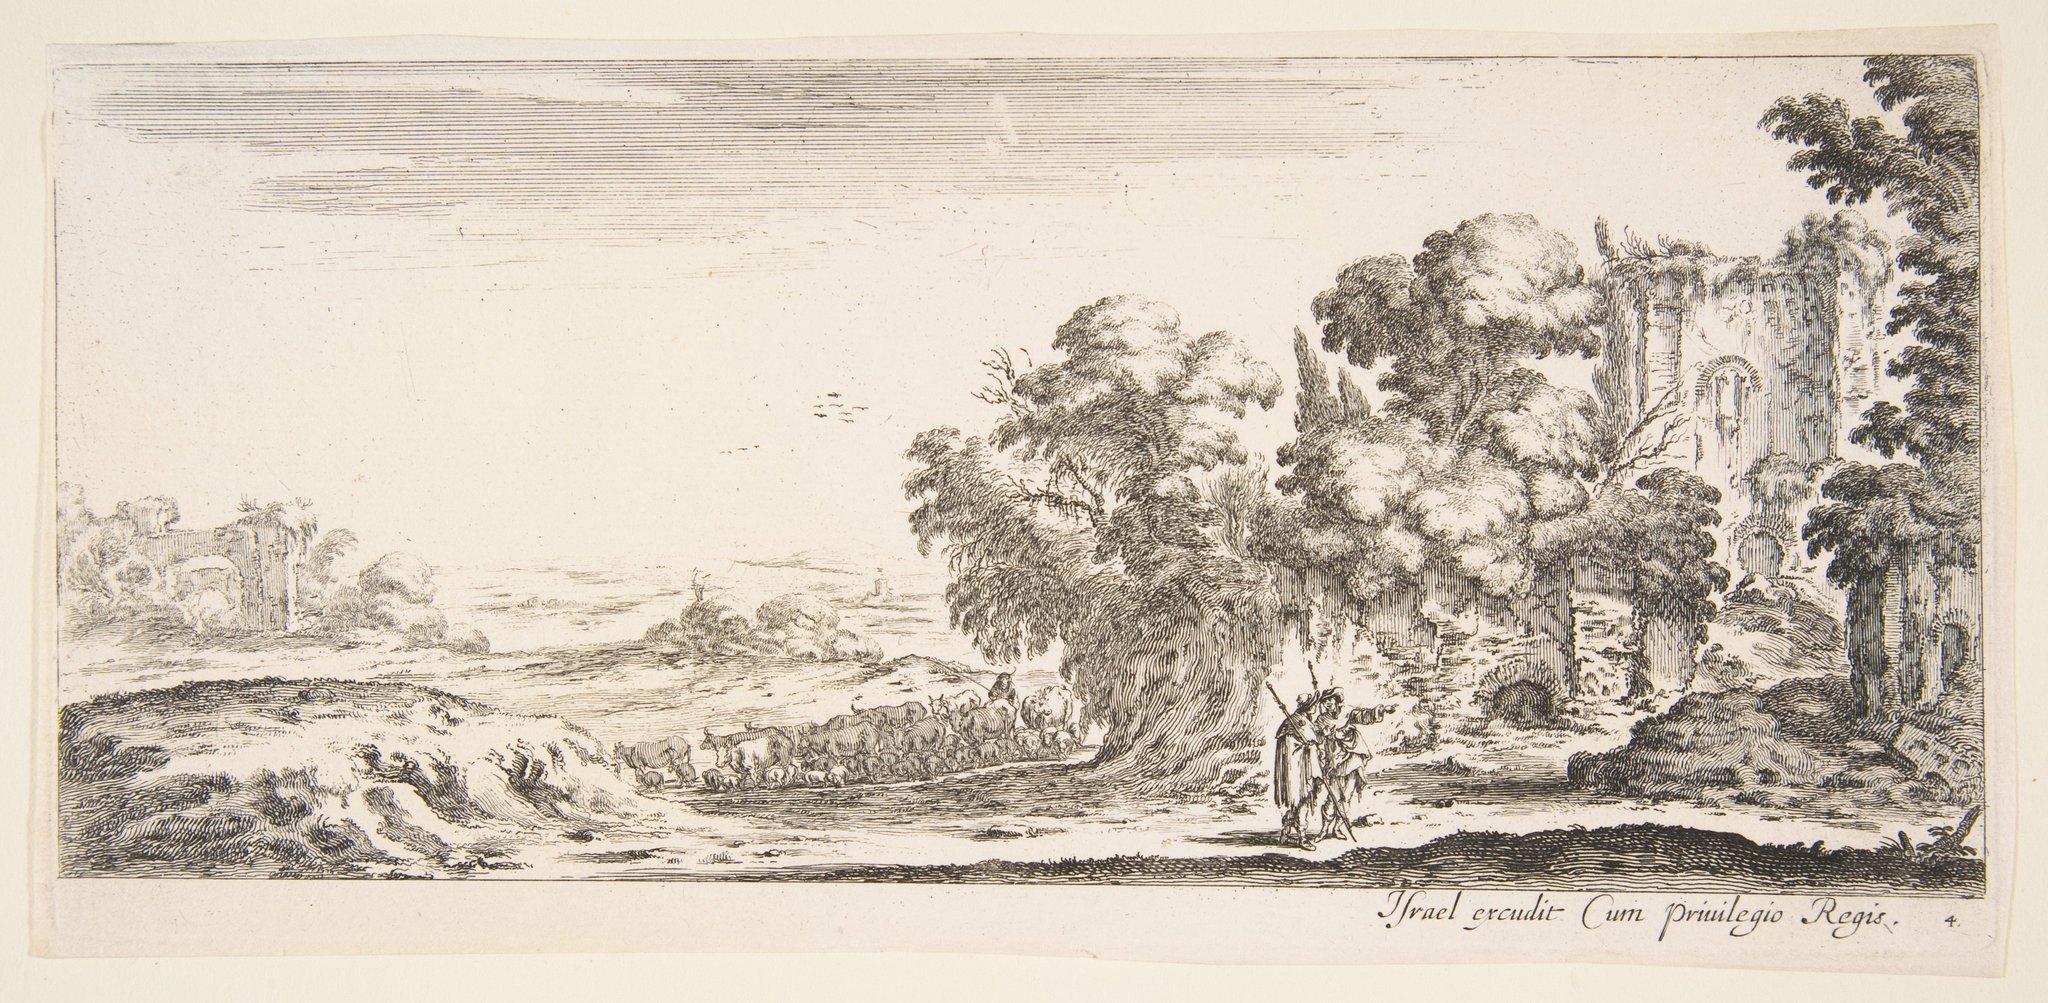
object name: print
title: Plate 4: two pilgrims observing ruins to right, one pointing towards the right, a shepherd and a herd of cattle in center background, from 'Various landscapes' (Divers paysages)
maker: stefano della bella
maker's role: artist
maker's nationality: italian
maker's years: 1610-1664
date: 1641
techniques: etching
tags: ruins,cows,landscapes,trees,shepherds